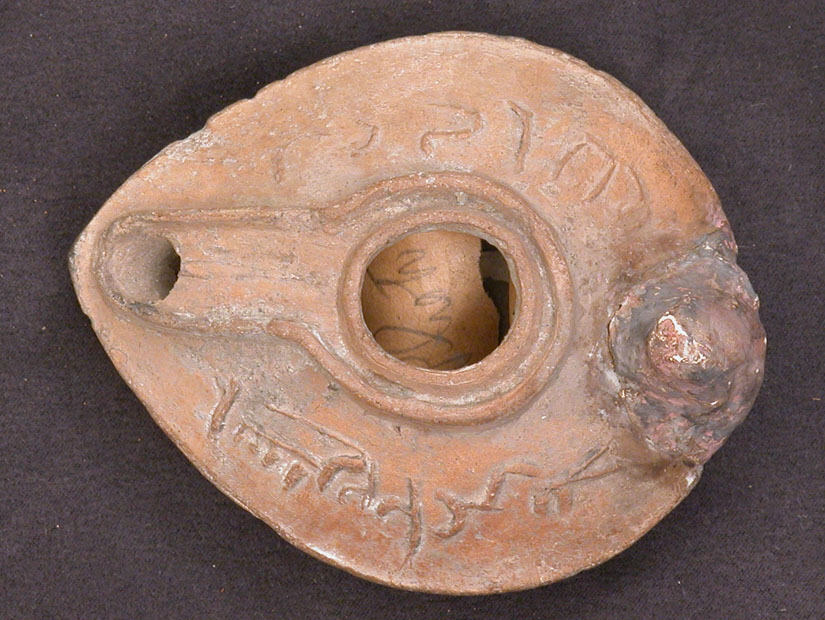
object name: lamp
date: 601-800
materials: earthenware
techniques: molding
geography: palestine